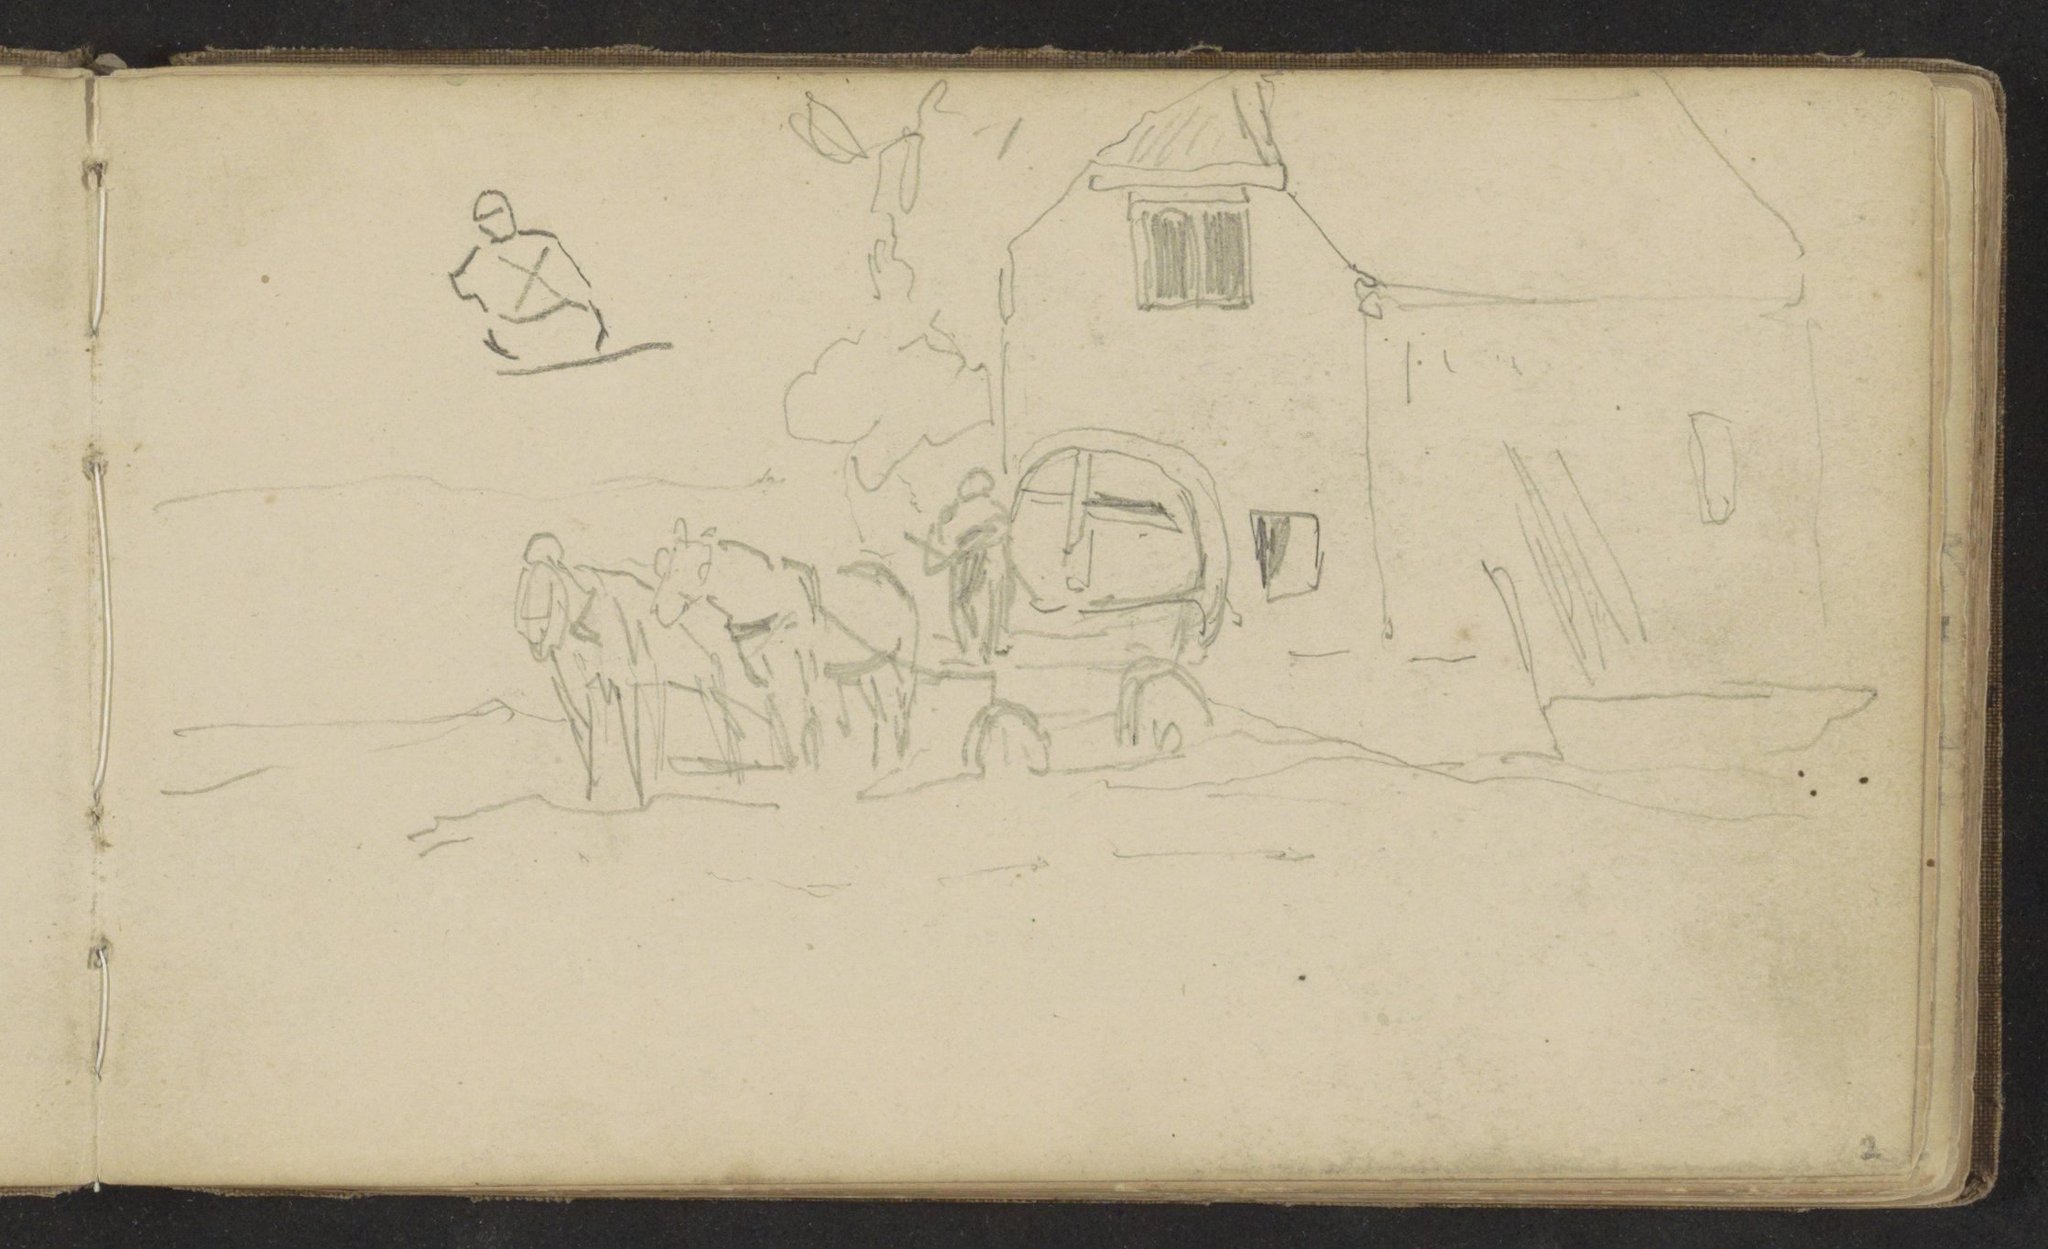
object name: sketchbook leaf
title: Wagen met twee paarden voor een huis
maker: johan hendrik weissenbruch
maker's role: draughtsman, painter, print maker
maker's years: 1824-1903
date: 1834-1903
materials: paper, pencil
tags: animal traction, animal-drawn vehicle (carriage etc.), cottage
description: Tevens een studie van een zittende man. Blad 2 recto uit een schetsboek met 43 bladen.